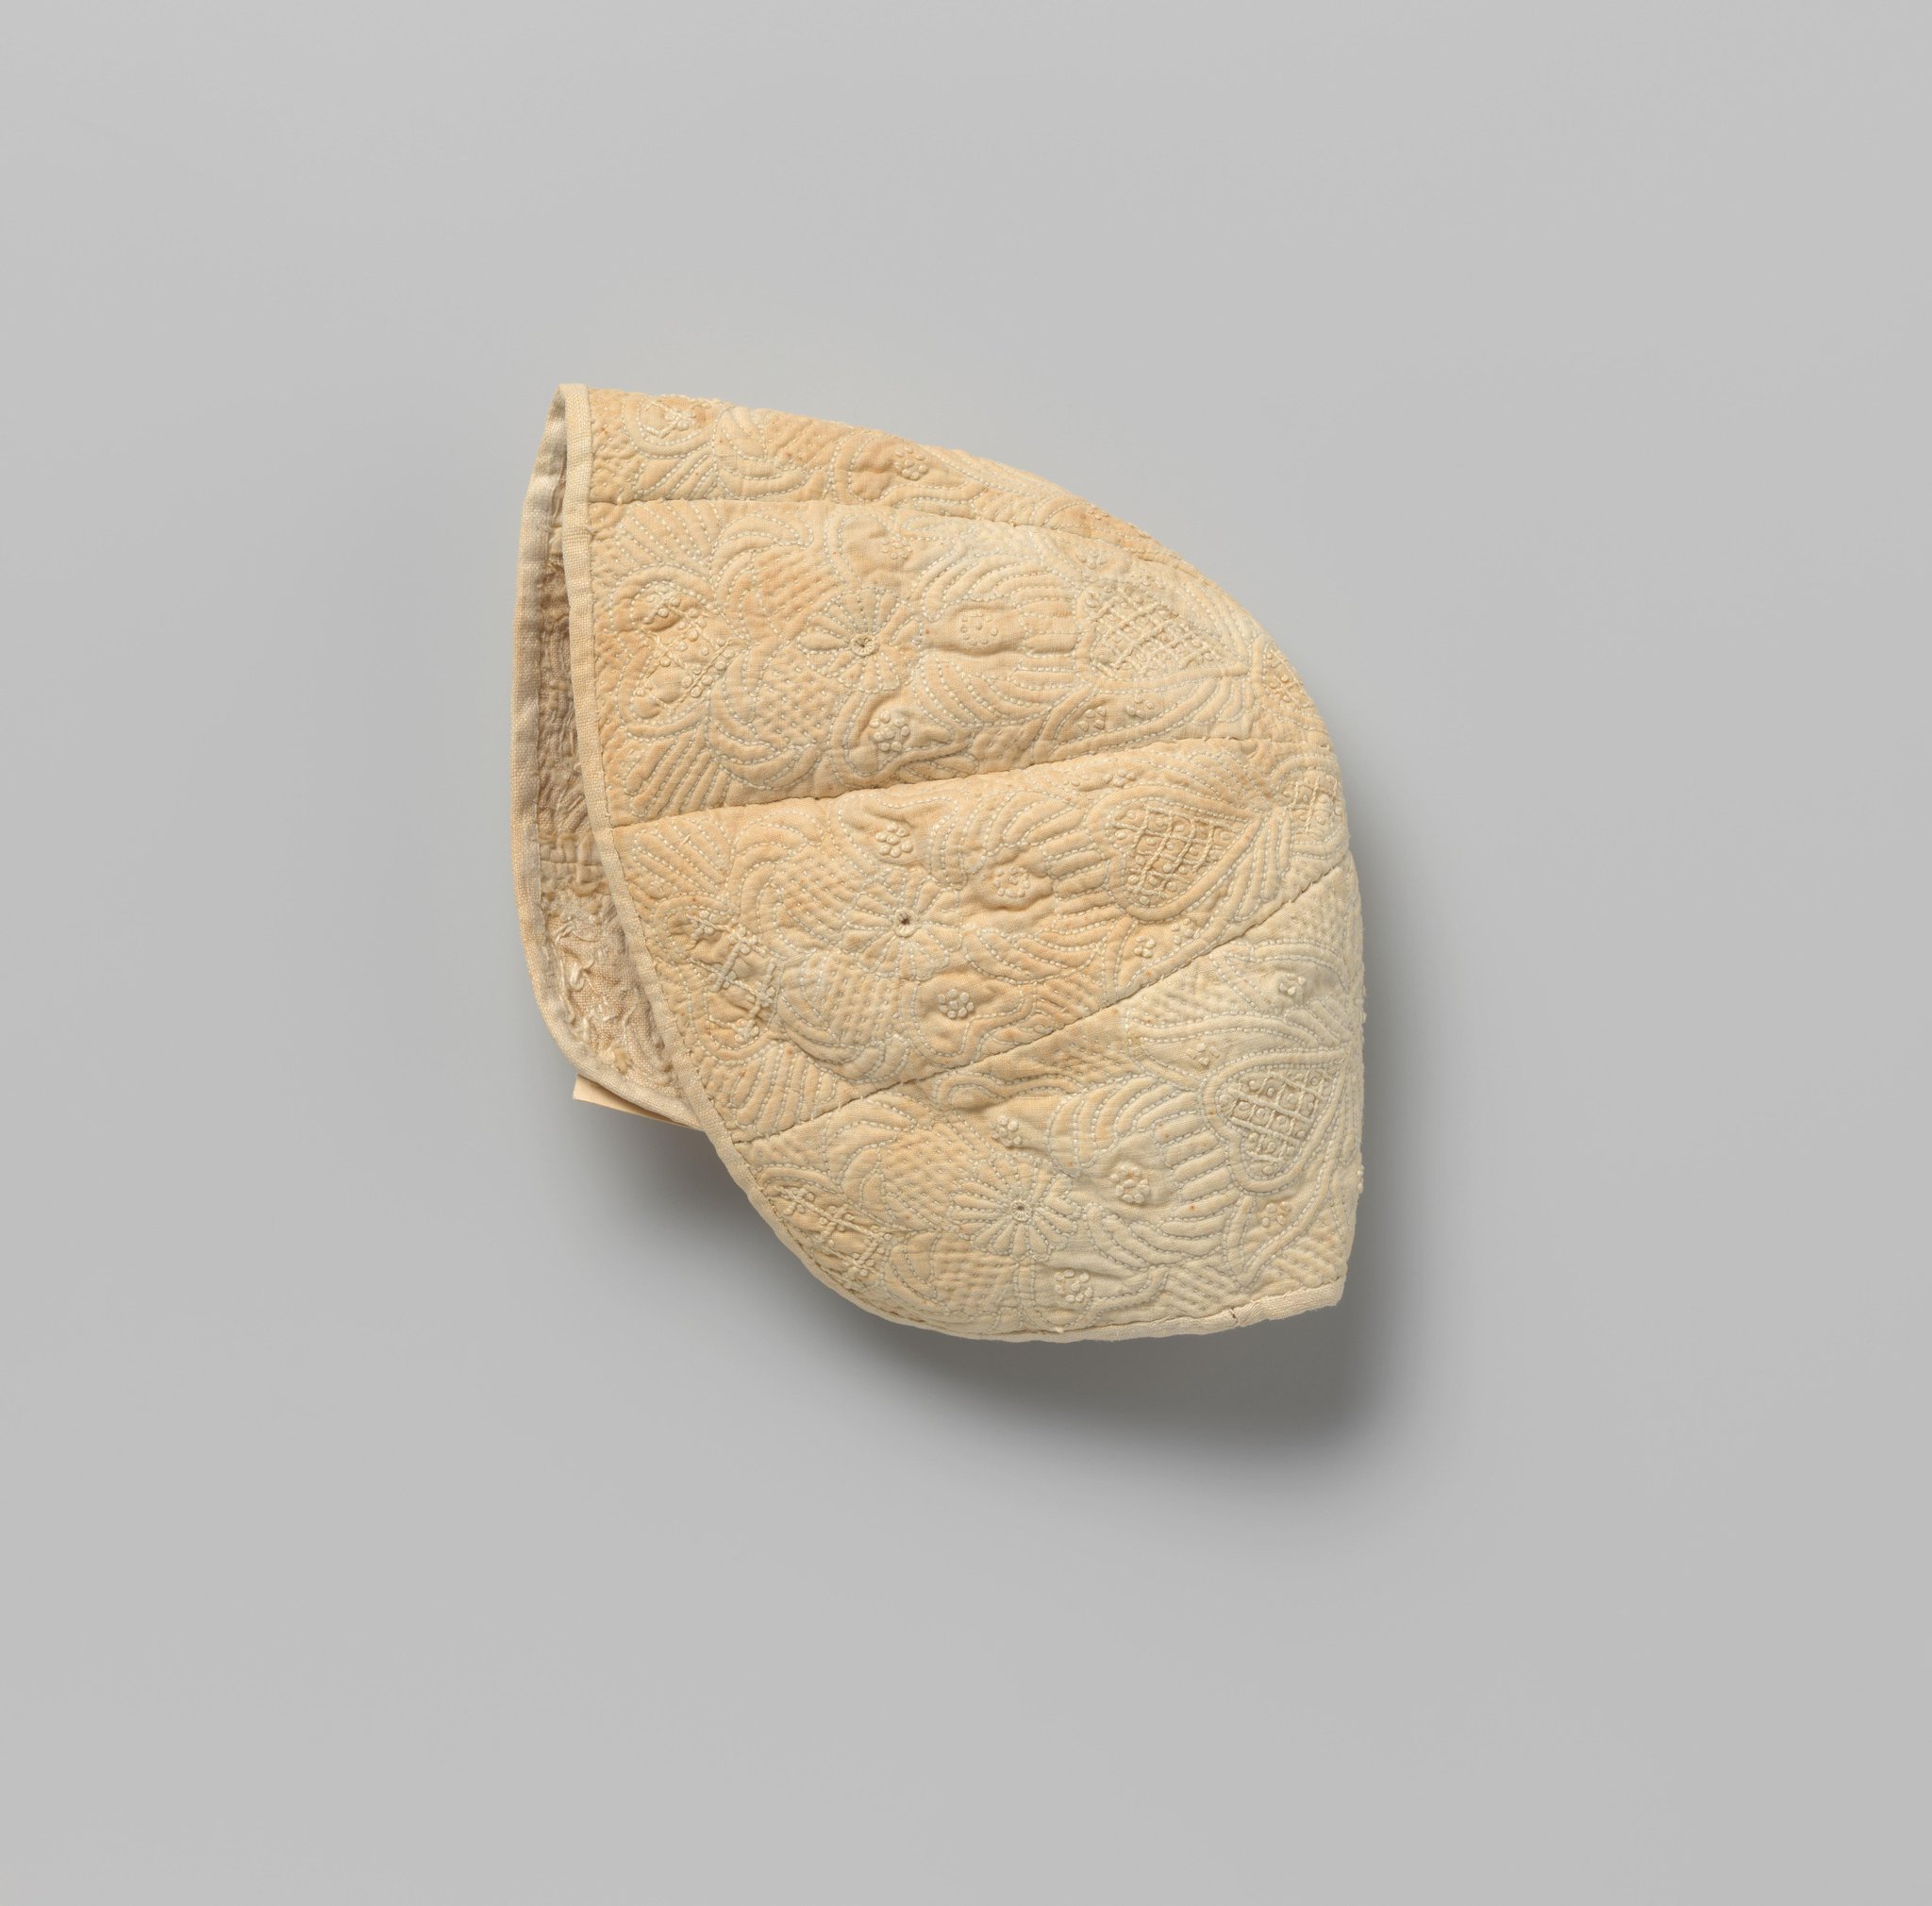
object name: cap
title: Kindermuts van linnen, met Zaans stikwerk en borduurwerk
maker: Anonymous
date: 1700-1800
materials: linen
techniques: embroidered, quilting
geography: netherlands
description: Kindermuts van gestikt linnen. Zaans stikwerk.